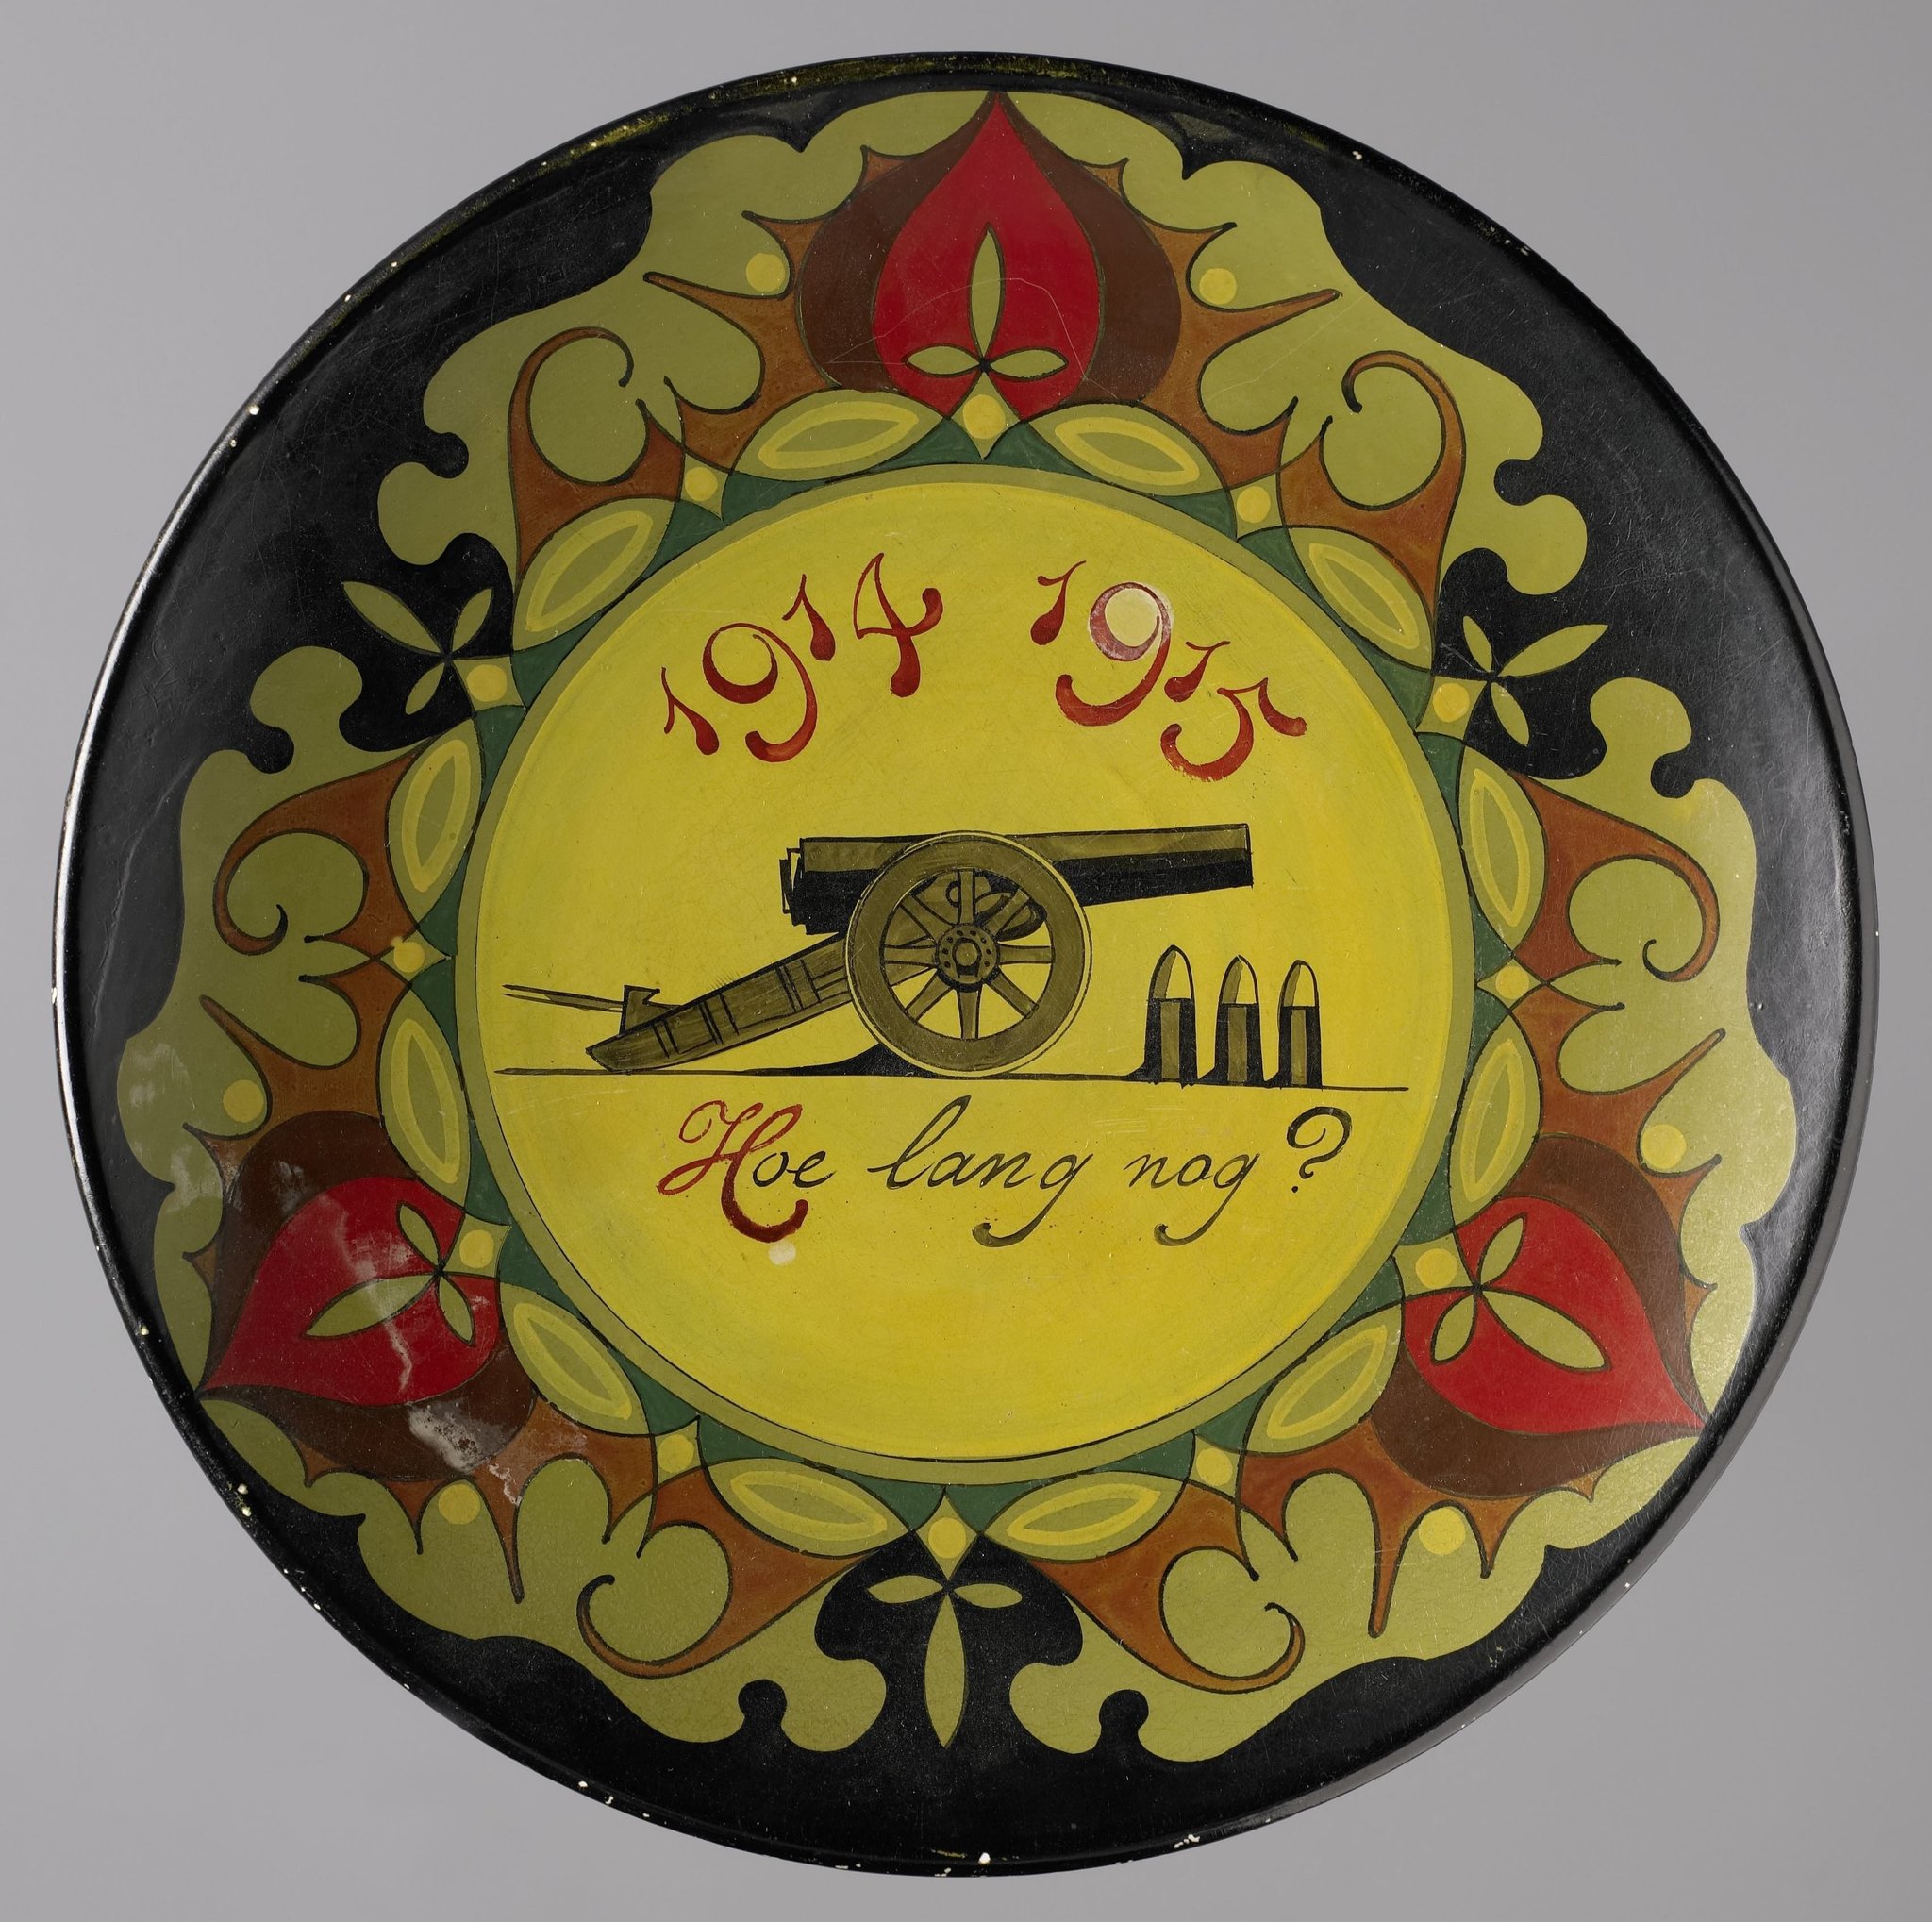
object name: commemorative plate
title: Hoe lang nog?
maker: johannes hendricus de groot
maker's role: ceramicist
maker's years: 1883-1951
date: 1914-1915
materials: earthenware, glaze, oil, varnish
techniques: firing, painted, varnishing, vitrification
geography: nijmegen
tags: eerste wereldoorlog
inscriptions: mark: ‘OC 2’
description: Wit geglazuurd bord met een veelkleurige beschildering over het gehele oppervlak en rand van voorzijde. Buitenrand met geometrische motieven op zwarte ondergrond. Centraal in rond kader: kanon op rolpaard met rechts hiervan drie granaten. Hieronder opschrift. Keerzijde: merk en 2 gaatjes in ondergrond.